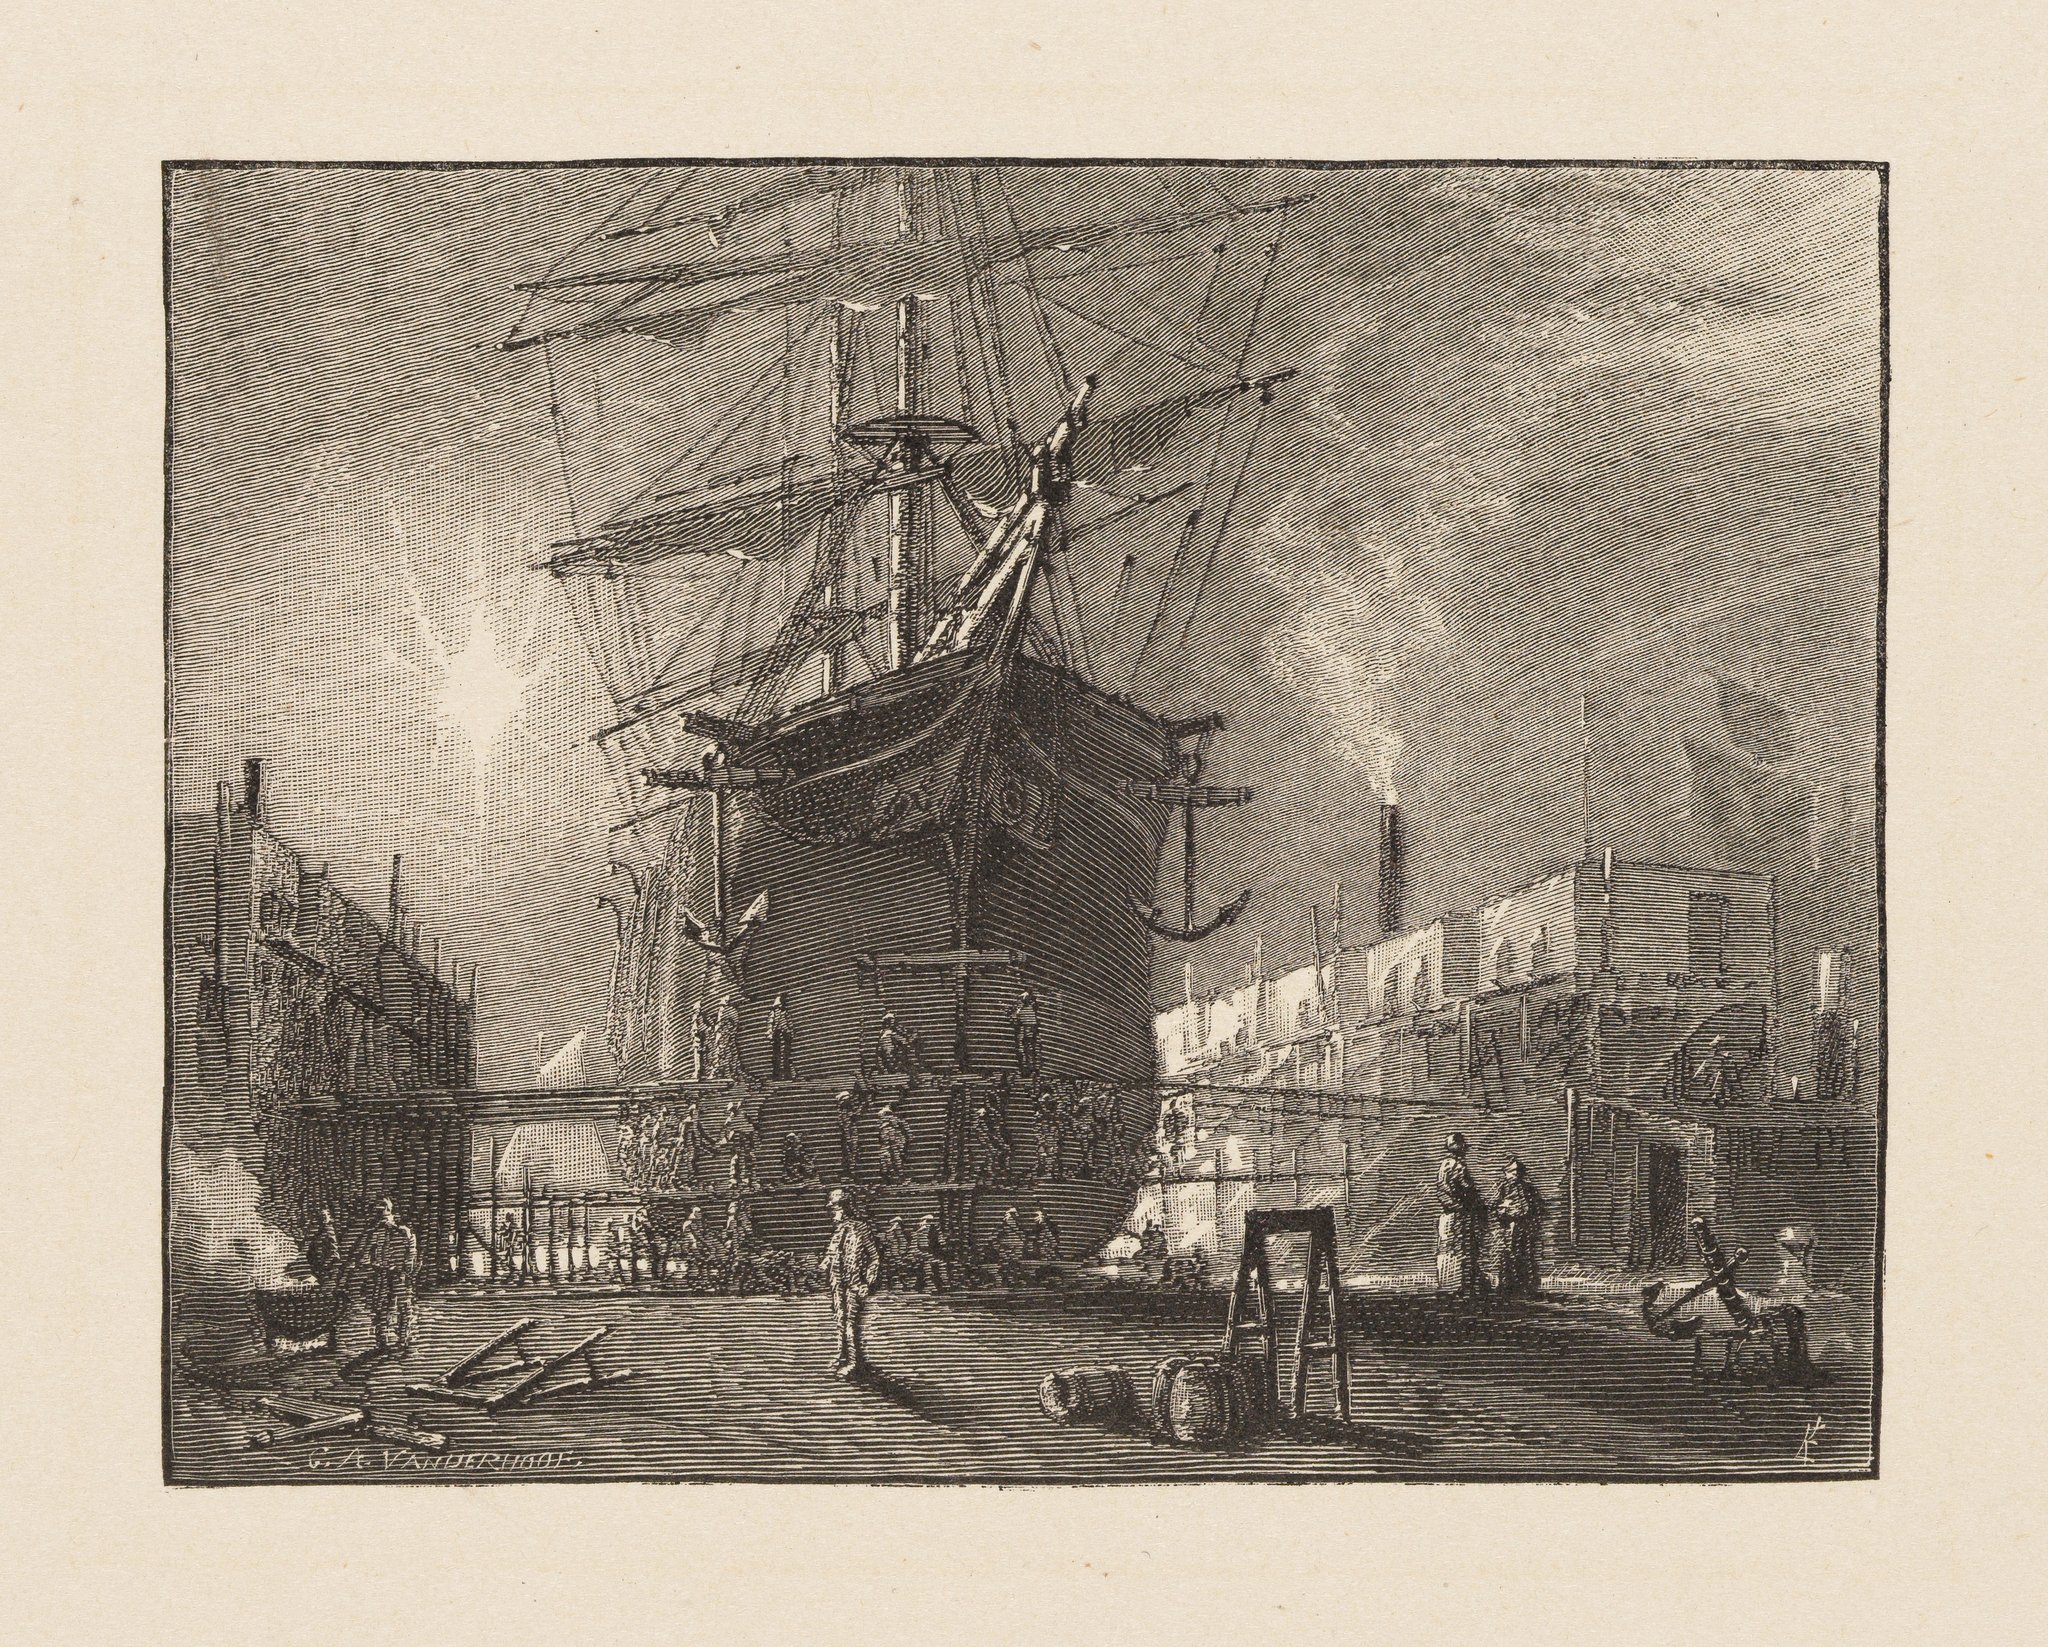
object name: print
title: Sectional Docks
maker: elbridge kingsley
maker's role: artist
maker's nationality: american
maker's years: 1841-1918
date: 1860-1915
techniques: engraving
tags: ships